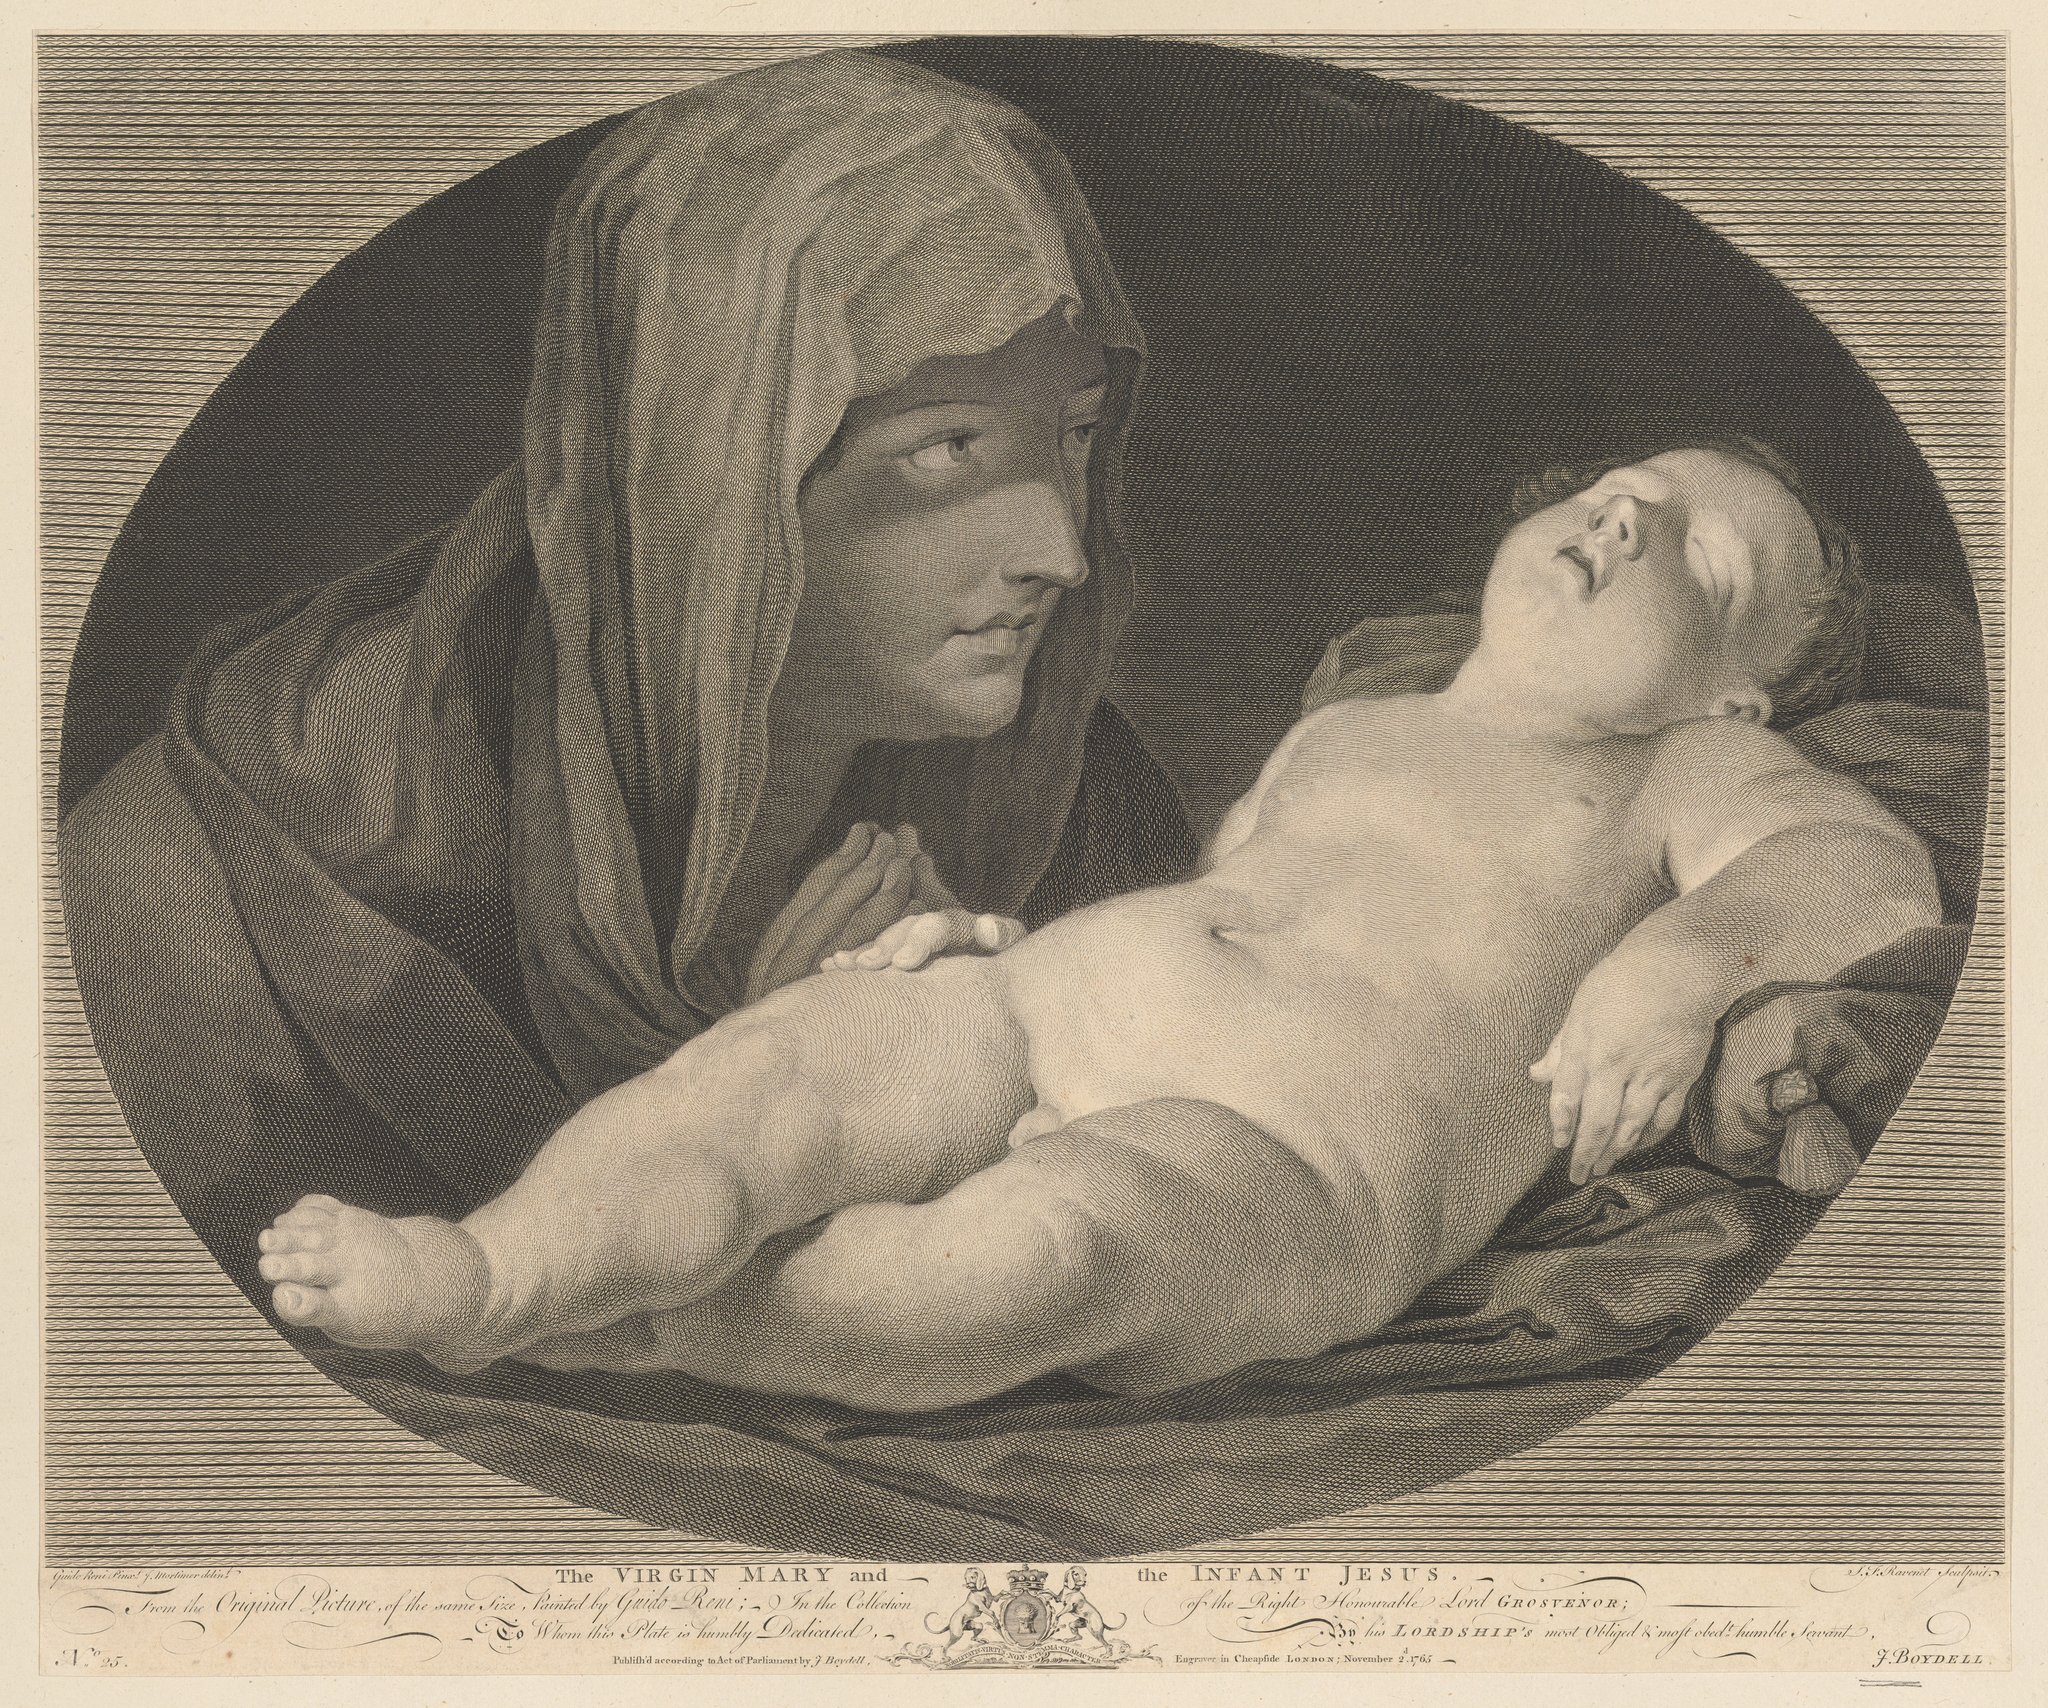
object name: print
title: The Virgin in prayer, looking at the sleeping infant Christ, in an oval frame, after Reni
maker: simon francis ravenet, the elder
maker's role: artist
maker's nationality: french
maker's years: 1706-1774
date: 1765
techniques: engraving, etching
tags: sleeping,virgin mary,jesus